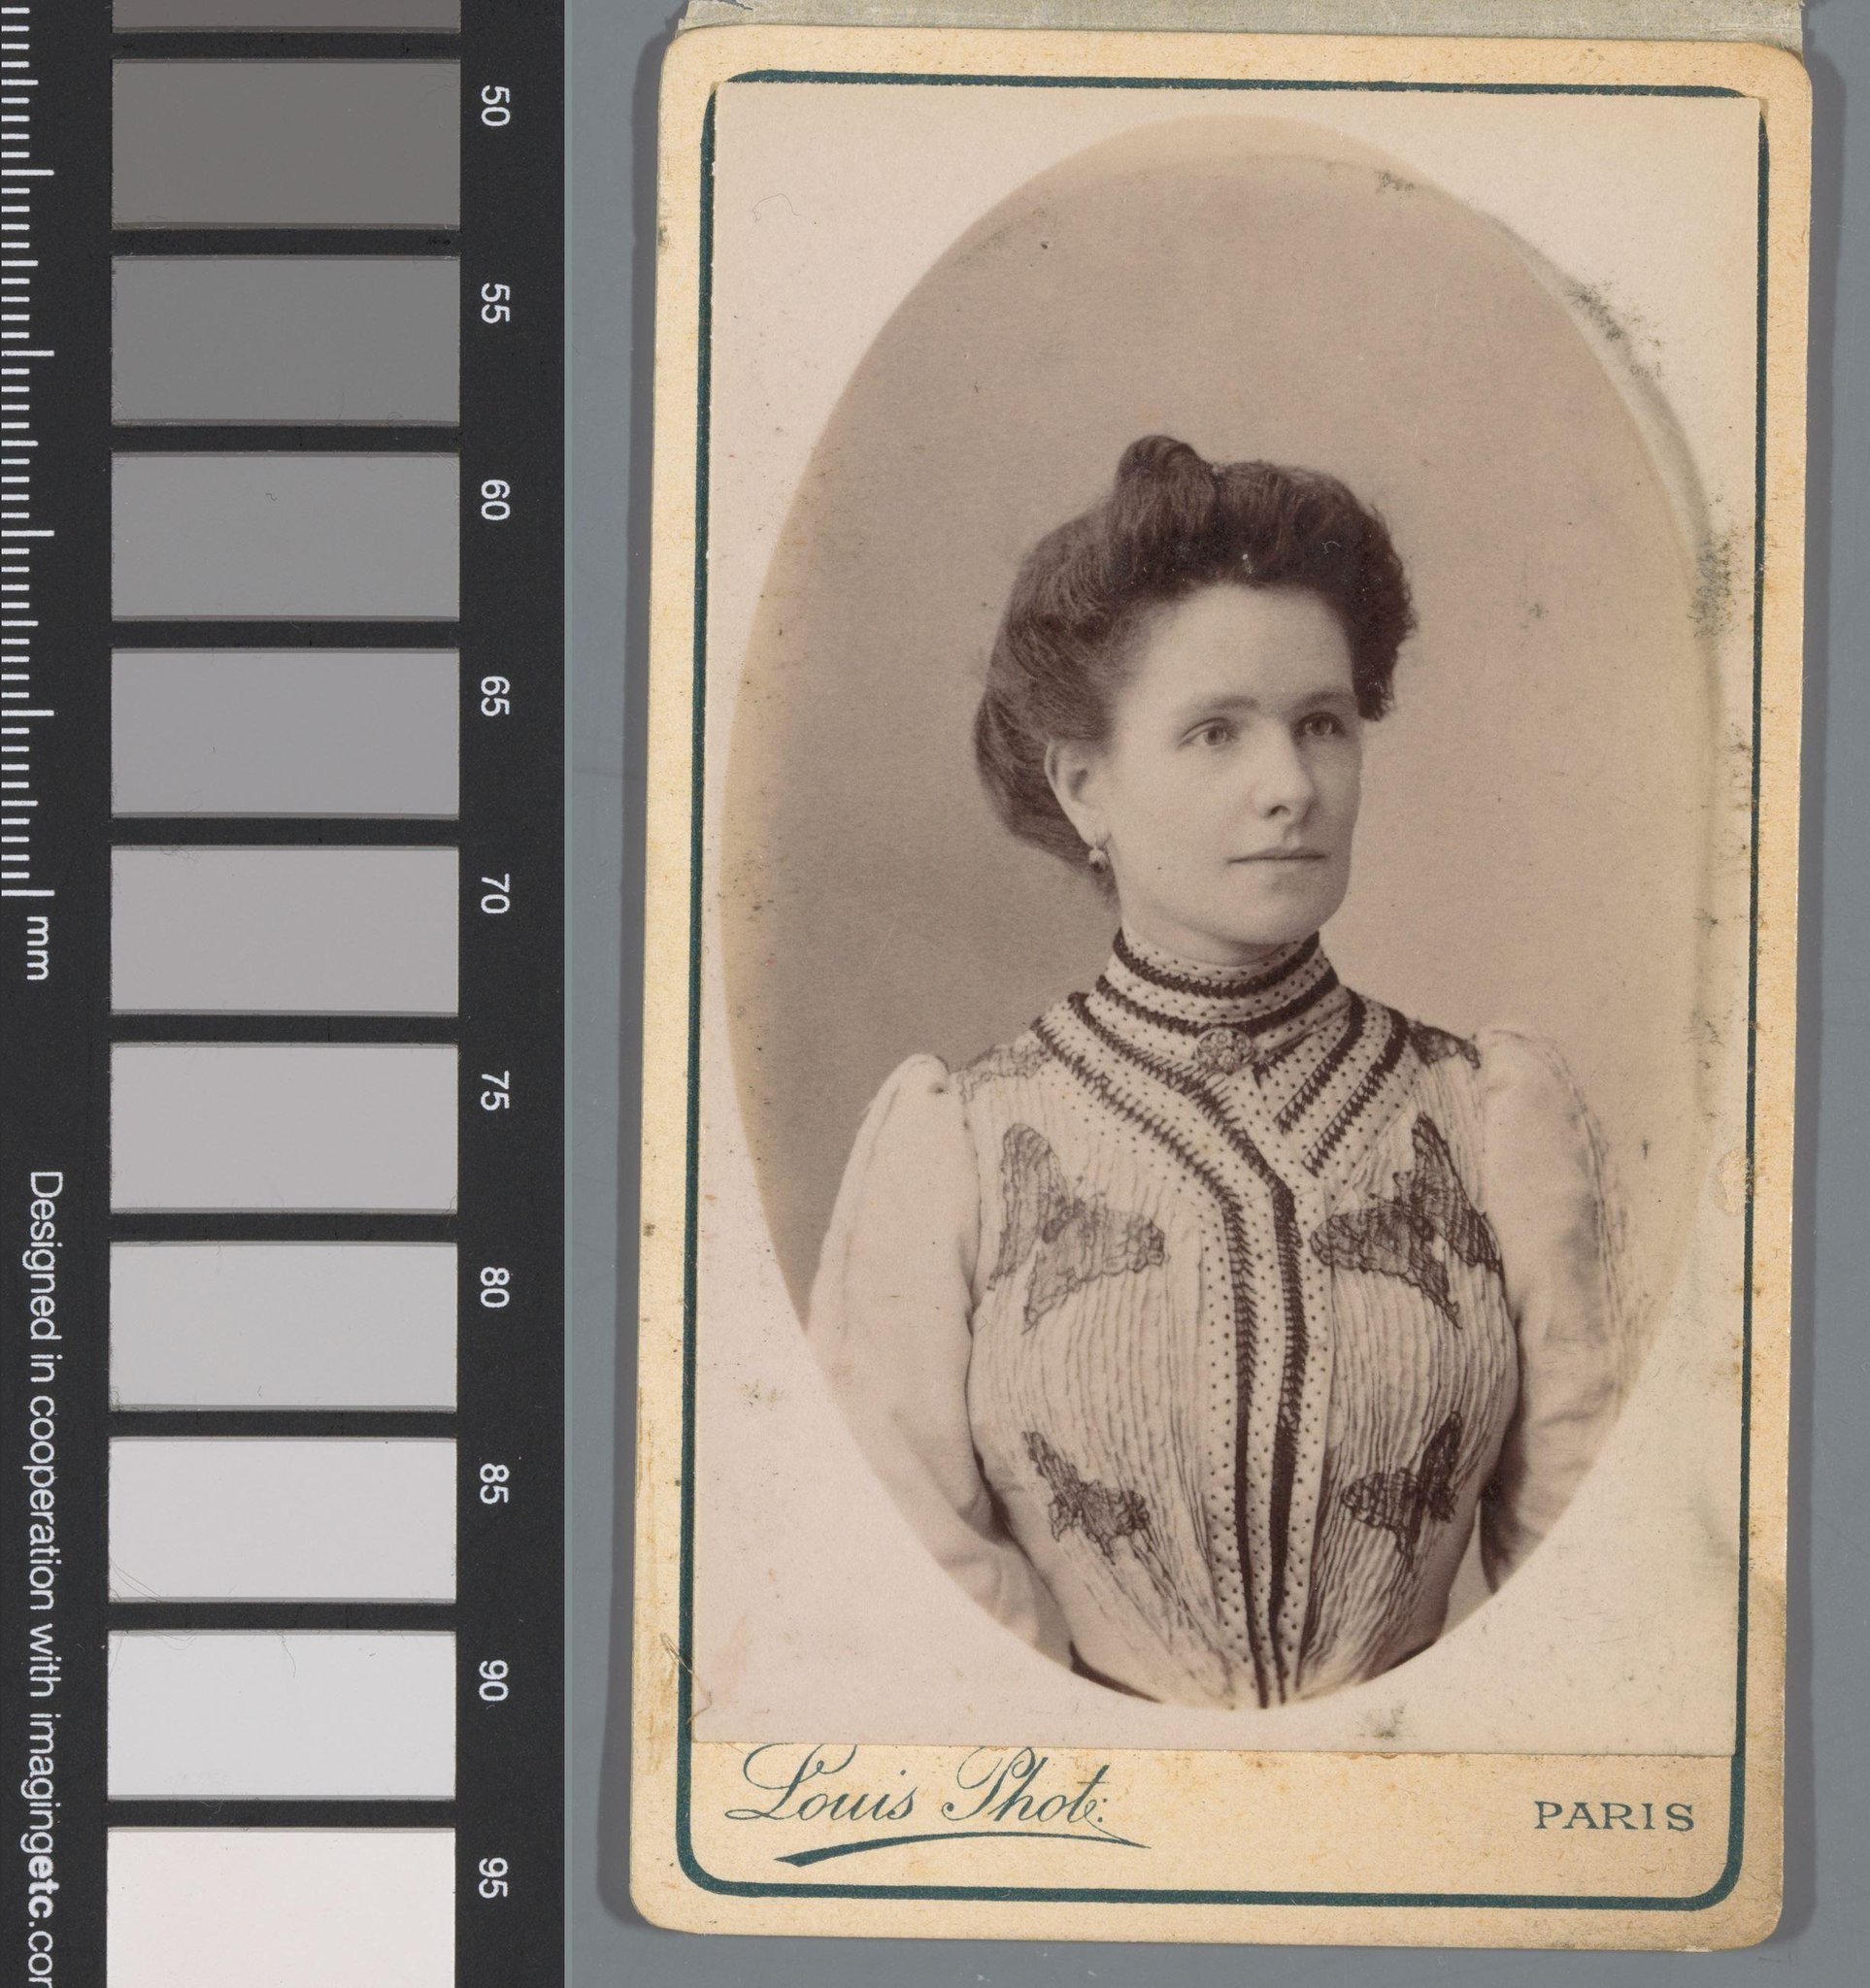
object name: photograph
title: Portret van een onbekende vrouw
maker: louis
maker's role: fotograaf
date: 1890-1914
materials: cardboard, celluloid, paper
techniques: albumen print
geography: paris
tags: adult woman, anonymous historical person portrayed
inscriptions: name: ‘Jules Simon, 47, R. de Flandre, Paris’, inscription: ‘NOUVEAU PROCÉDÉ ÉLECTRIQUE/ Breveté S.G.D.G./ Permettant d'óperer par n'importe quel temps/ et à n'importe quele heure du jour et de la NUIT/ Les Clichés sont conservés/ R. DECHAVANNES PARIS’, address: ‘29/ Boulevard St Martin/ en face du théatre de l'ambigu/ Station du Métropolitan/ (place de la république)/ PARIS’